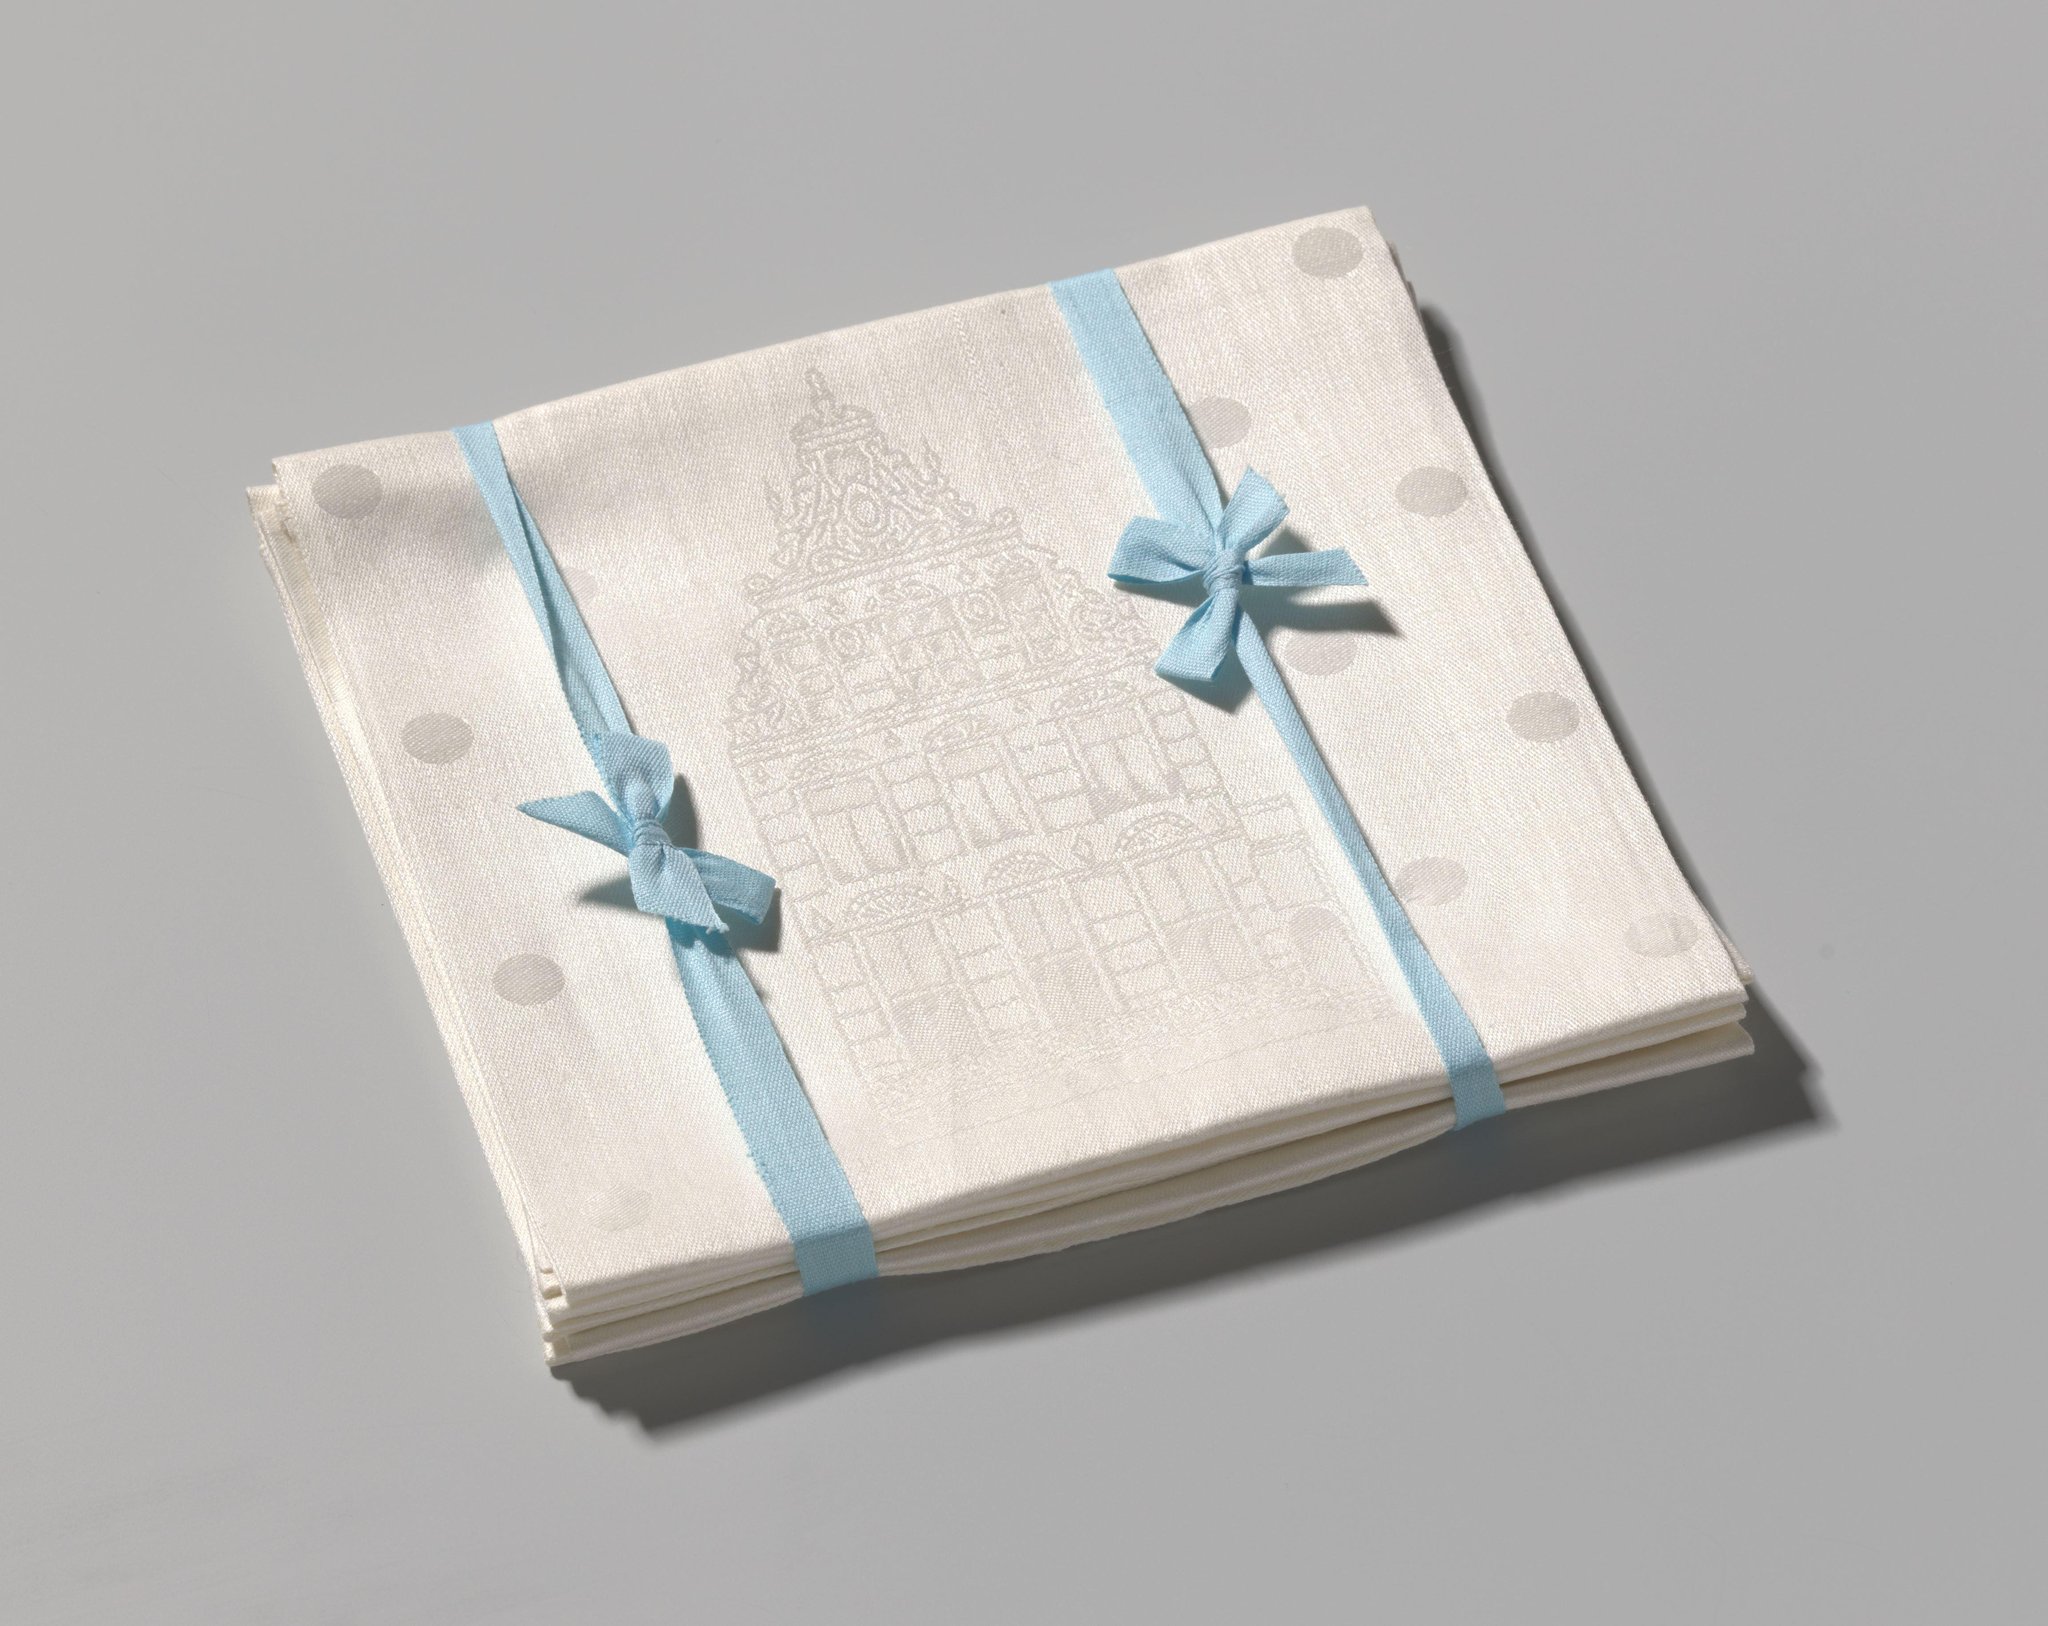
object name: napkin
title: Servet van linnendamast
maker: Anonymous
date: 1965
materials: linen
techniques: damask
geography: eindhoven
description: Linnen damasten servet ter herdenking van De Groote Societeit Groningen, 1765-1965".